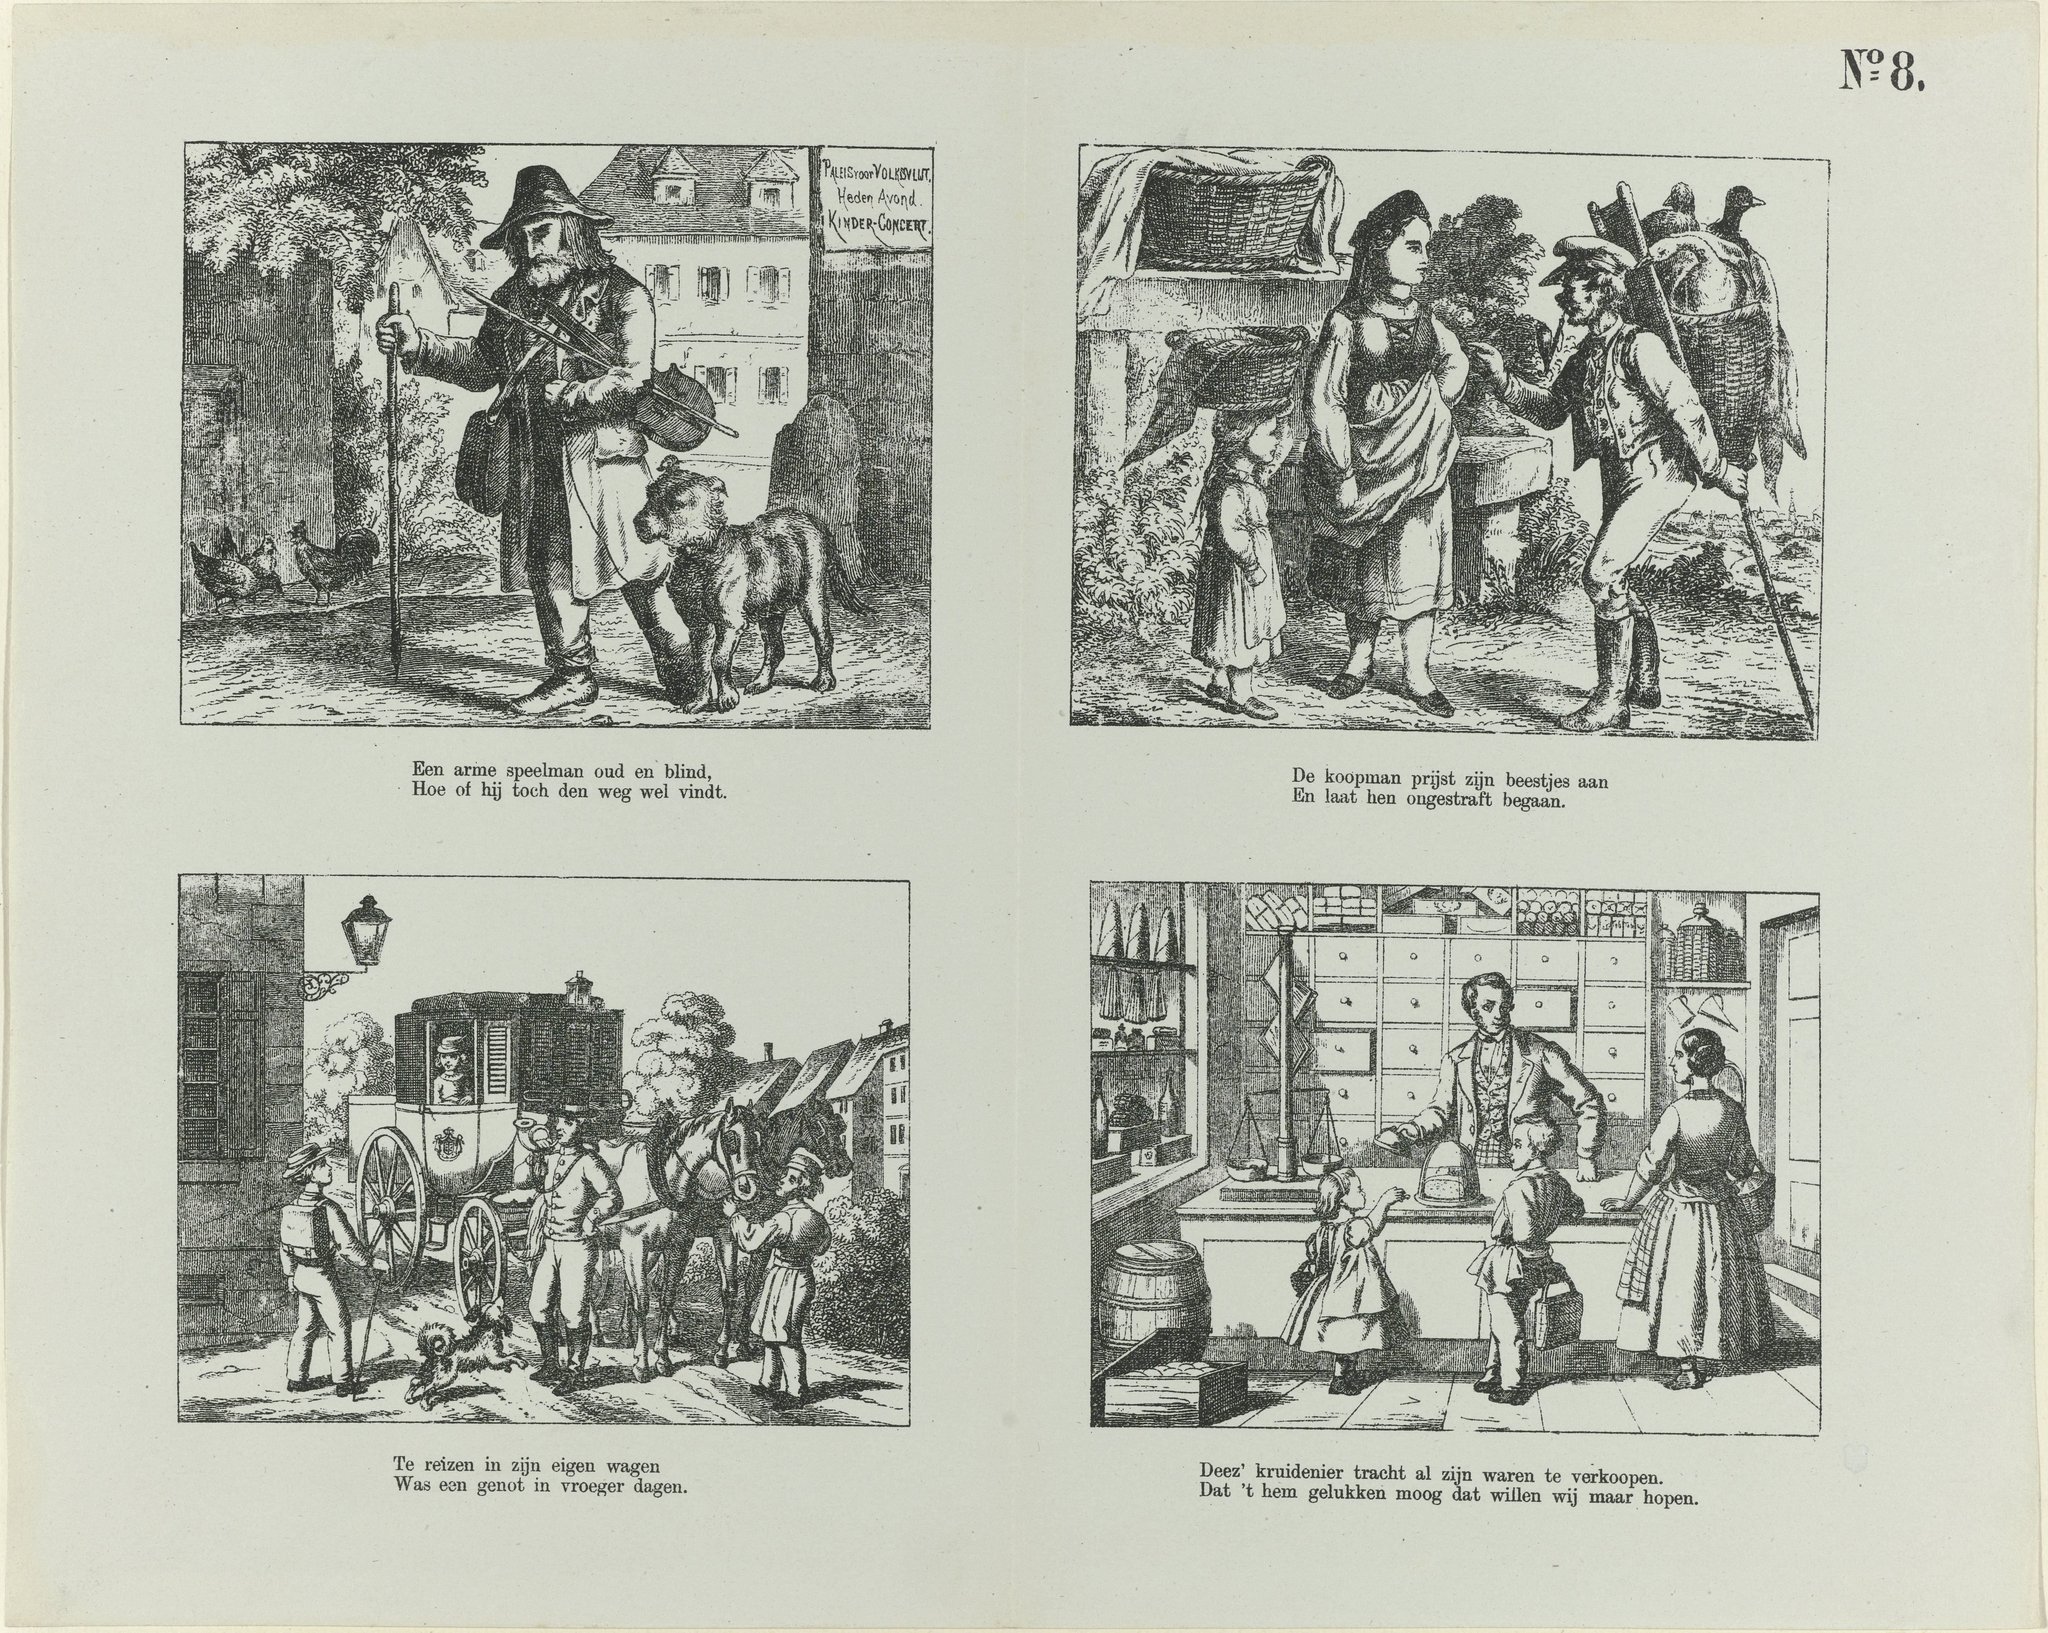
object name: print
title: Beroepen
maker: Anonymous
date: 1873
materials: paper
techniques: letterpress printing, lithograph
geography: amsterdam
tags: musician, street-trader, crafts and industries, merchant, salesman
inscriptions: collector's mark: Lugt 2760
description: Blad met 4 voorstellingen van beroepen, waaronder muzikant, koopman, diligence (reiskoets) bestuurder en kruidenier. Onder elke afbeelding een tweeregelig vers. Genummerd rechtsboven: No. 8.